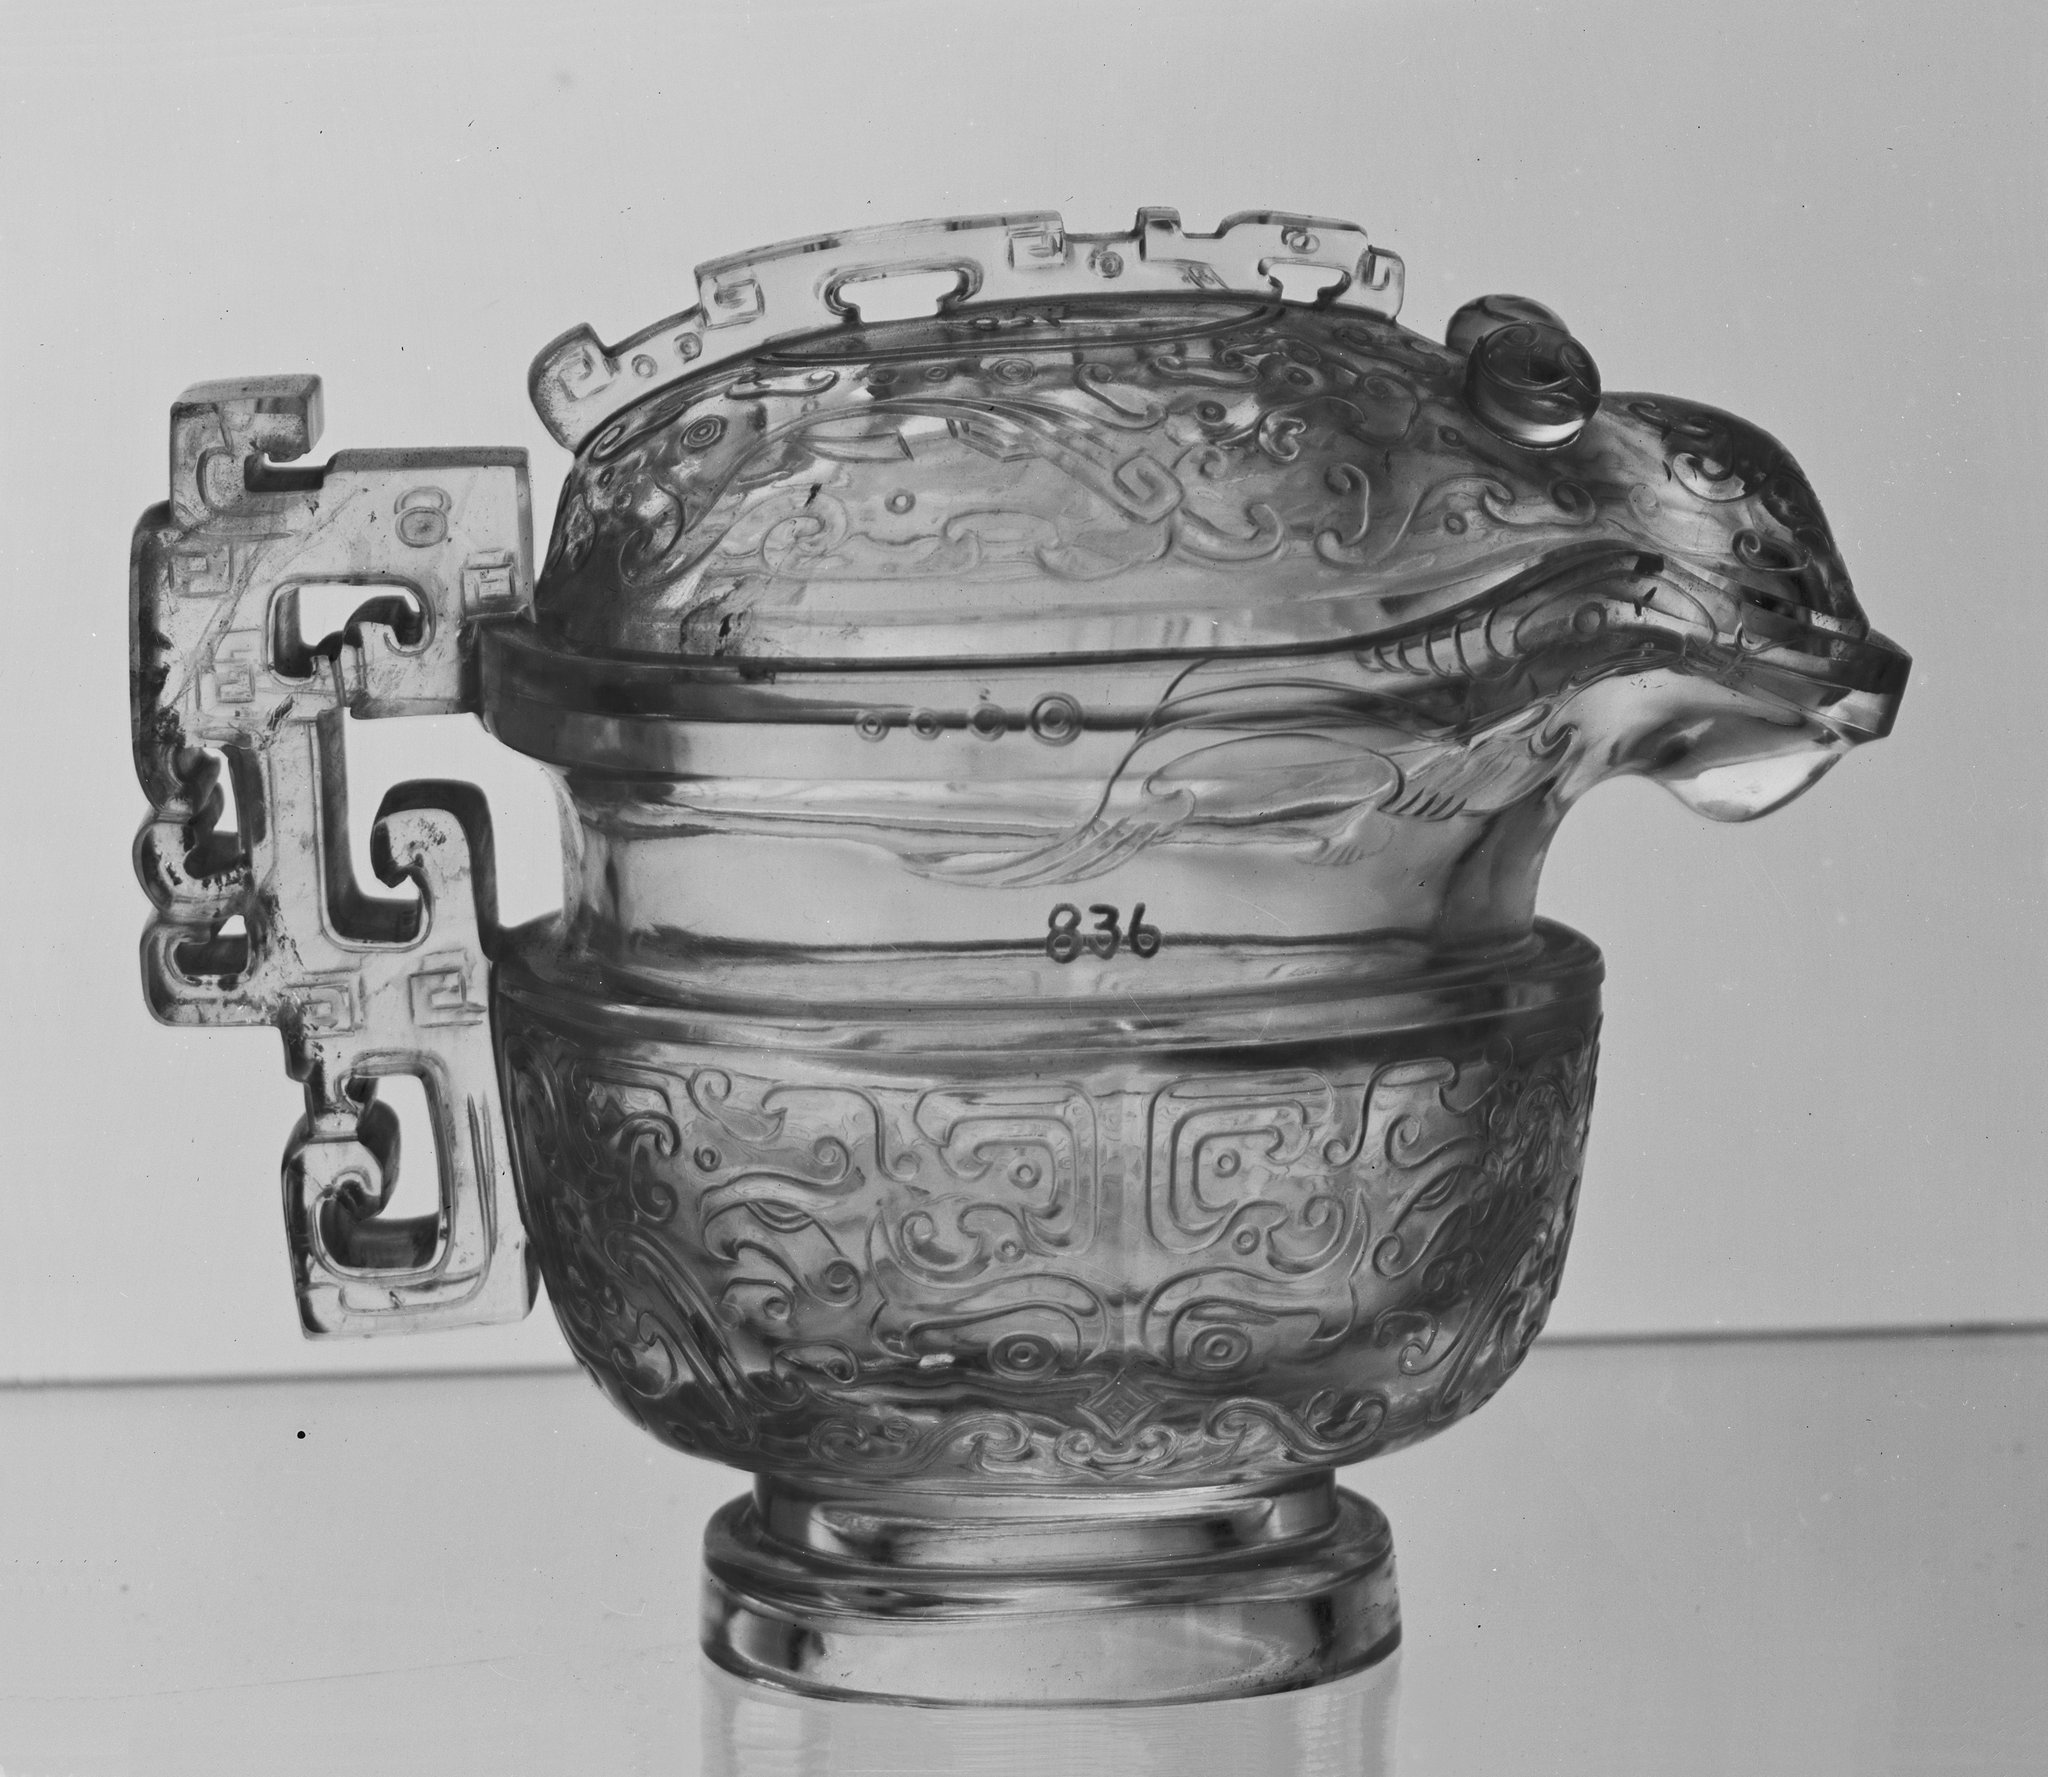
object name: vessel with cover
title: Sacrificial Vessel with Cover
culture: chinese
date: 1701-1800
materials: quartz